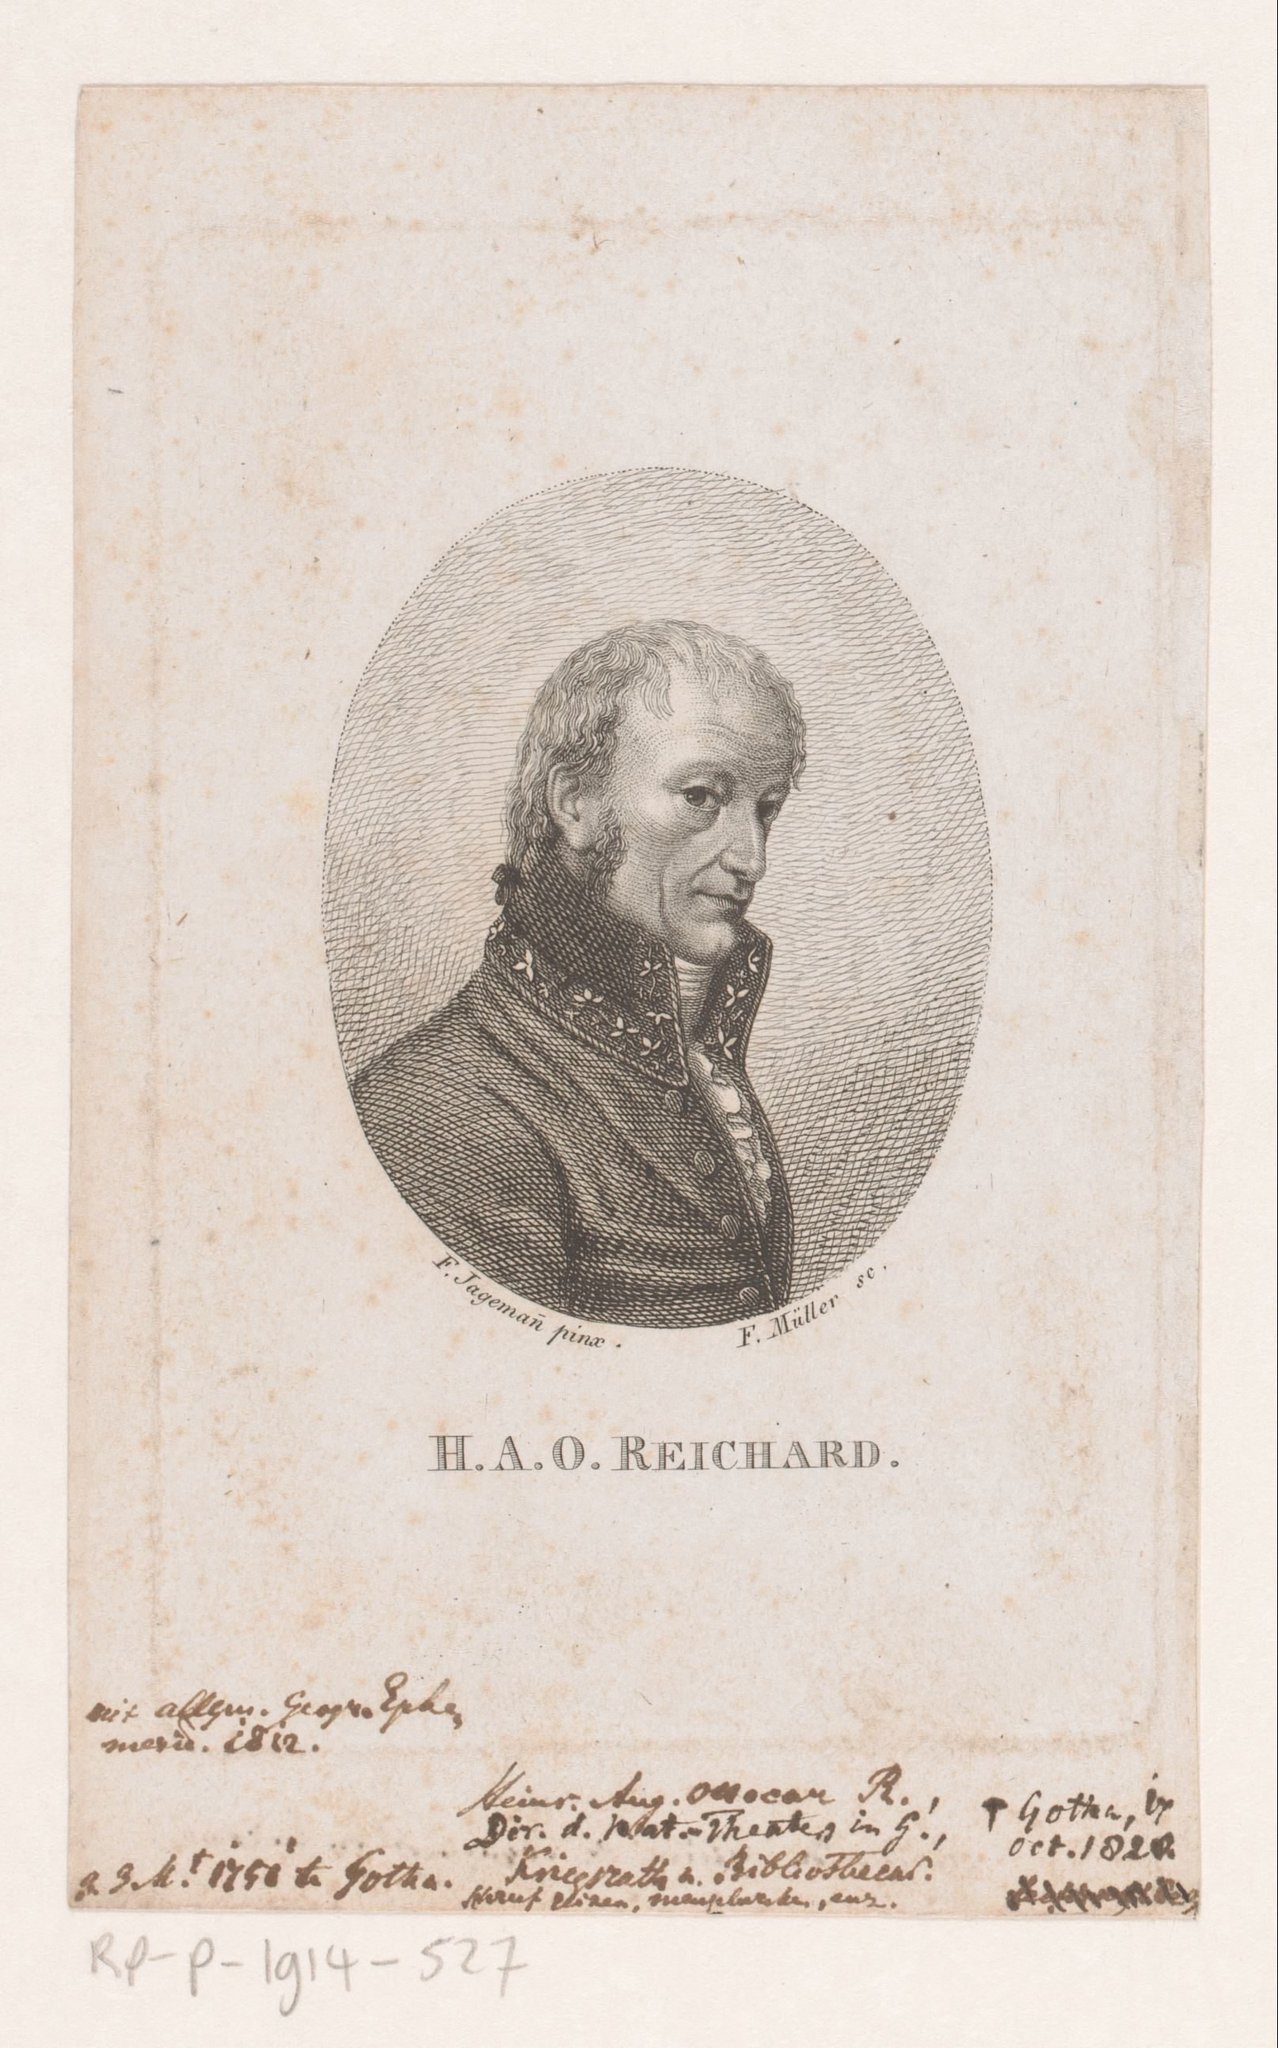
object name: print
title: Portret van Heinrich August Ottokar Reichard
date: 1792-1816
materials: paper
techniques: etching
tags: historical persons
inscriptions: collector's mark: Lugt 2228